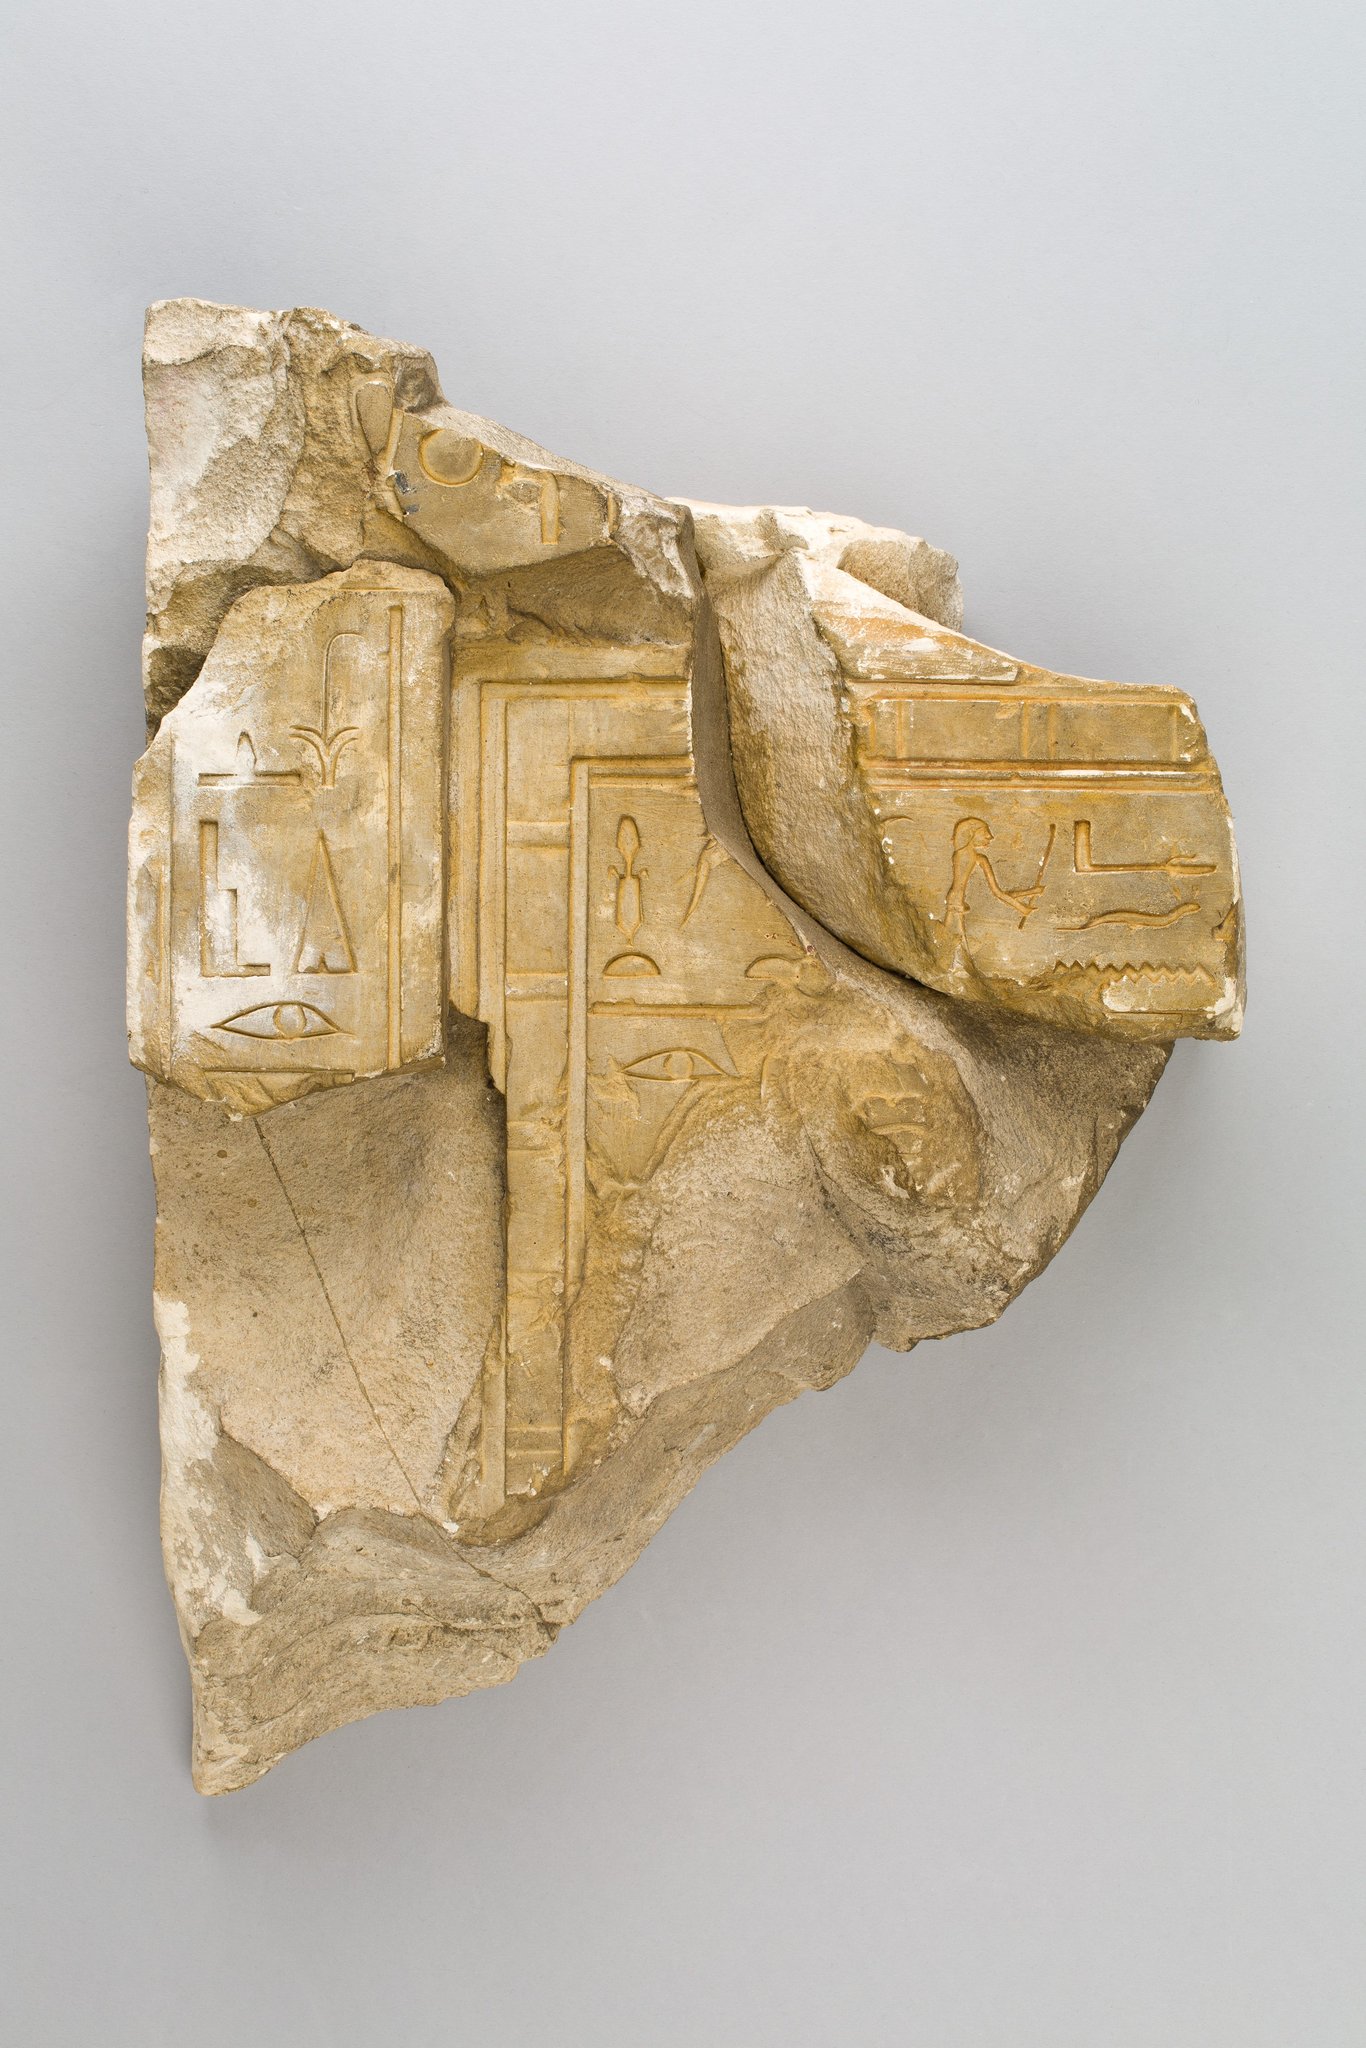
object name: stela, henenu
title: Fragments from the Stela of the Chief Steward Henenu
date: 2030-2000 BCE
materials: limestone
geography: egypt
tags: hieroglyphs